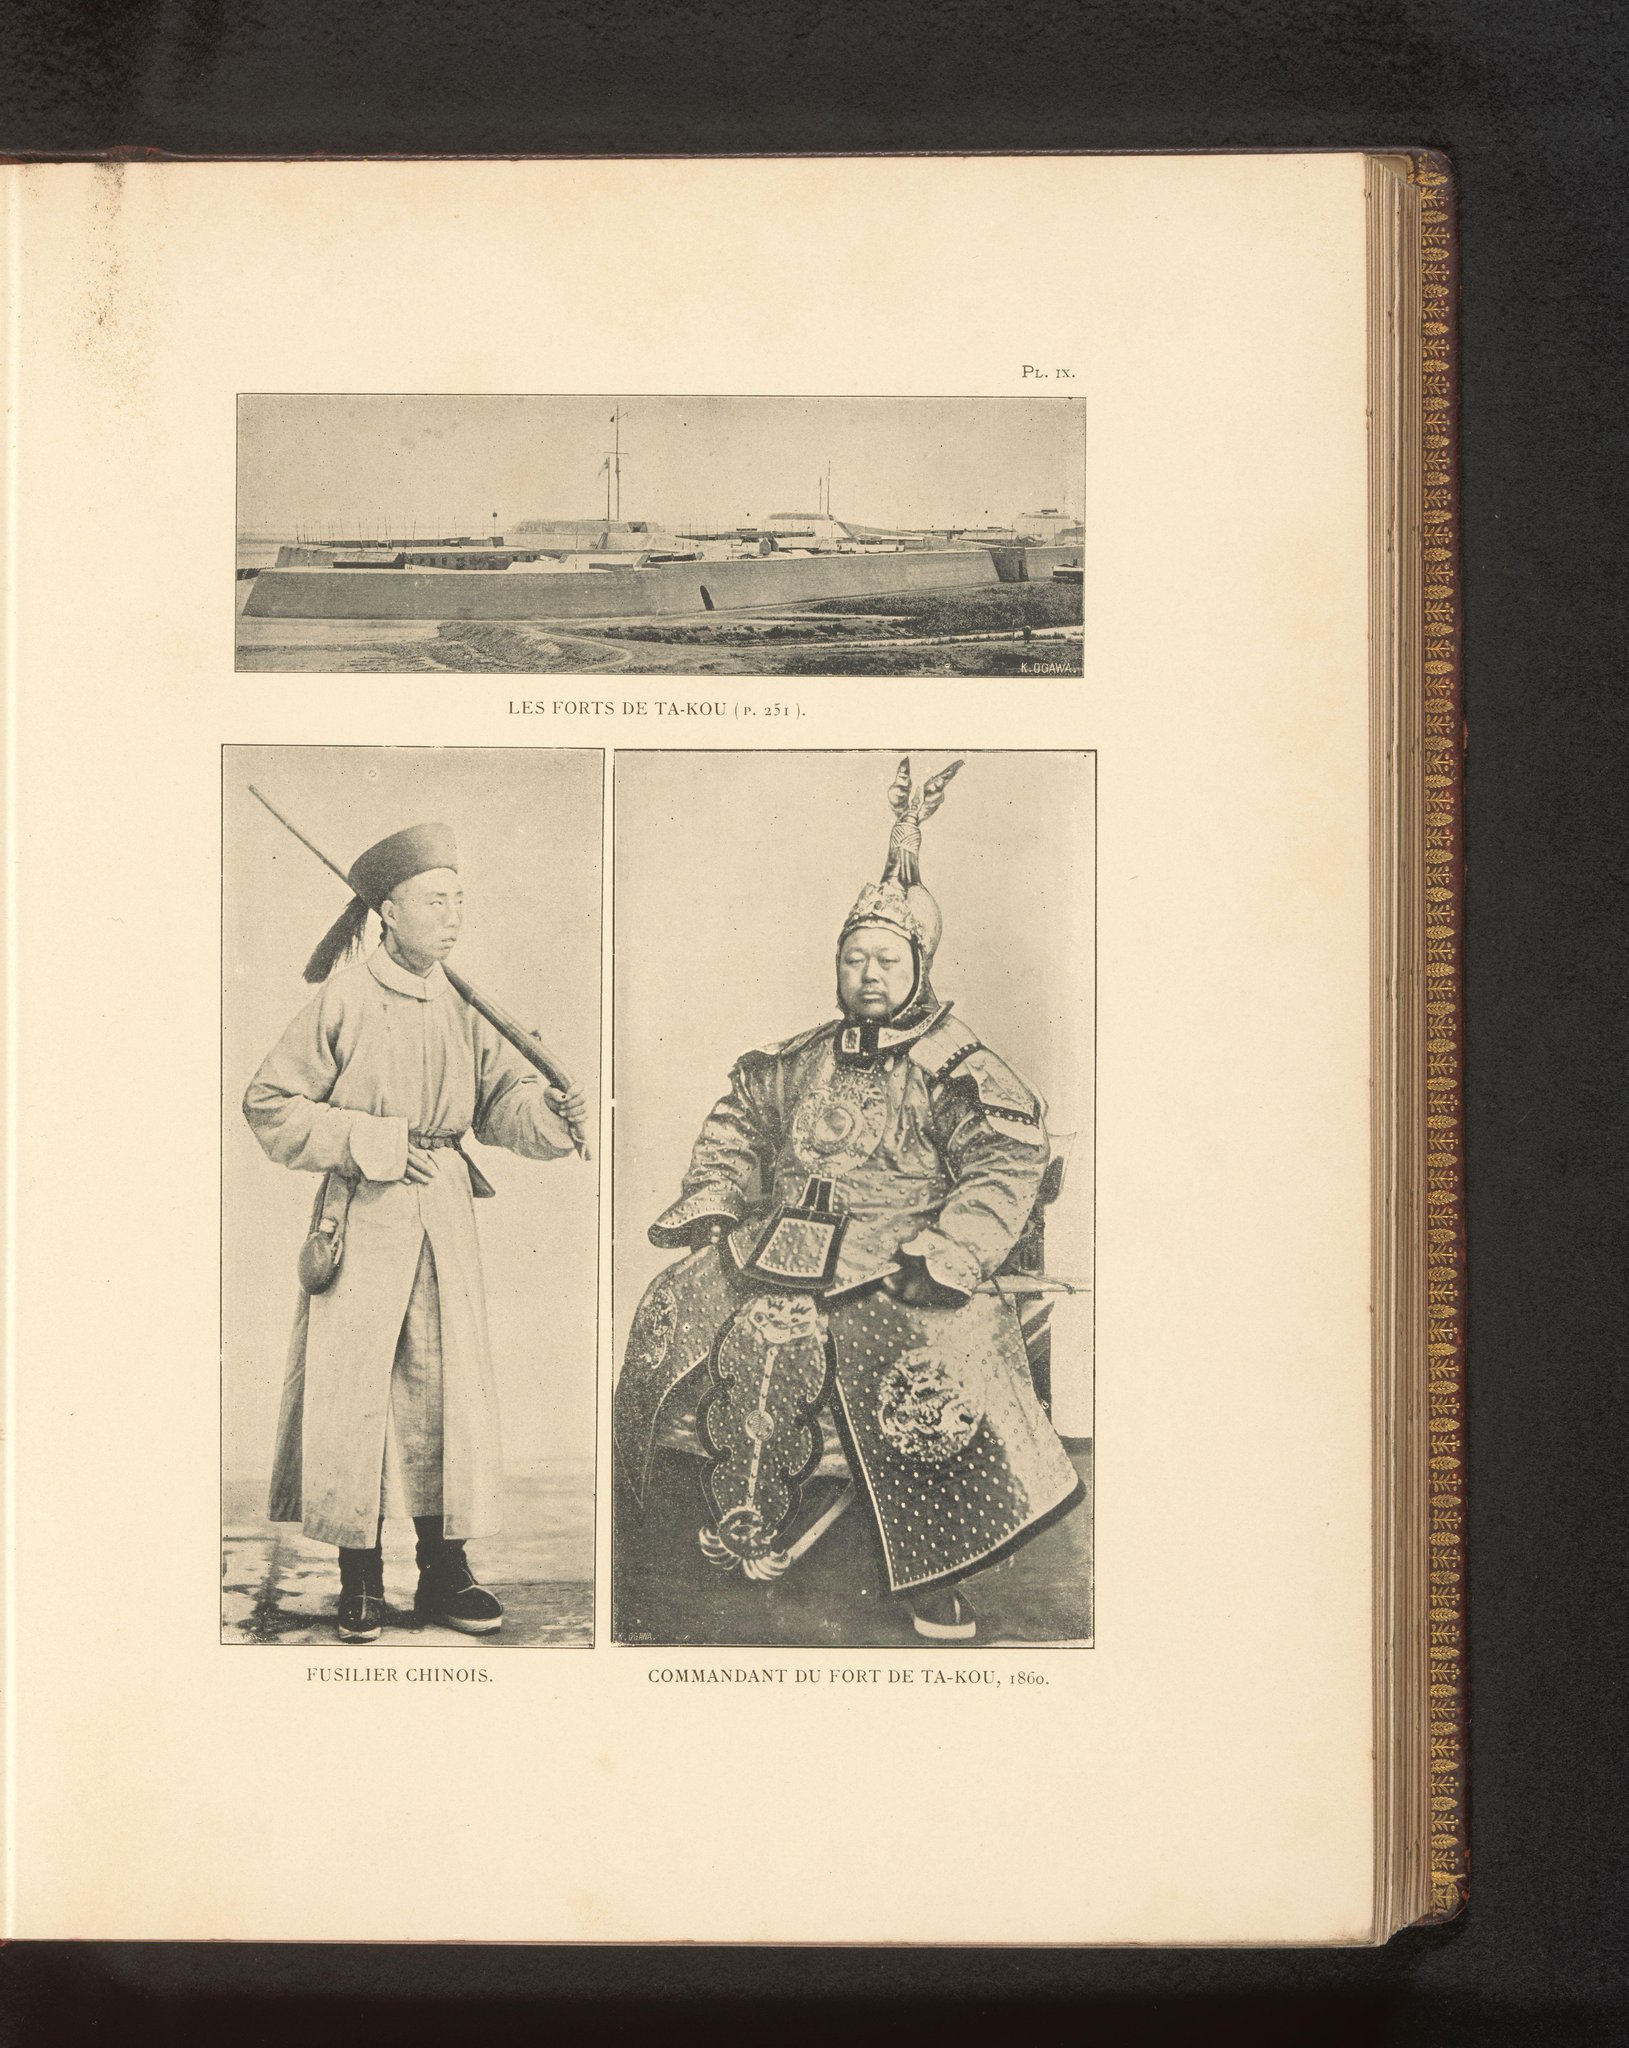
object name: page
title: Gezicht op een fort, Portret van een scherpschutter en Portret van de commandant van het fort bij Ta-Kou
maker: Anonymous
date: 1892-1897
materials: paper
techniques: autotype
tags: fortress, historical persons, firearms, china